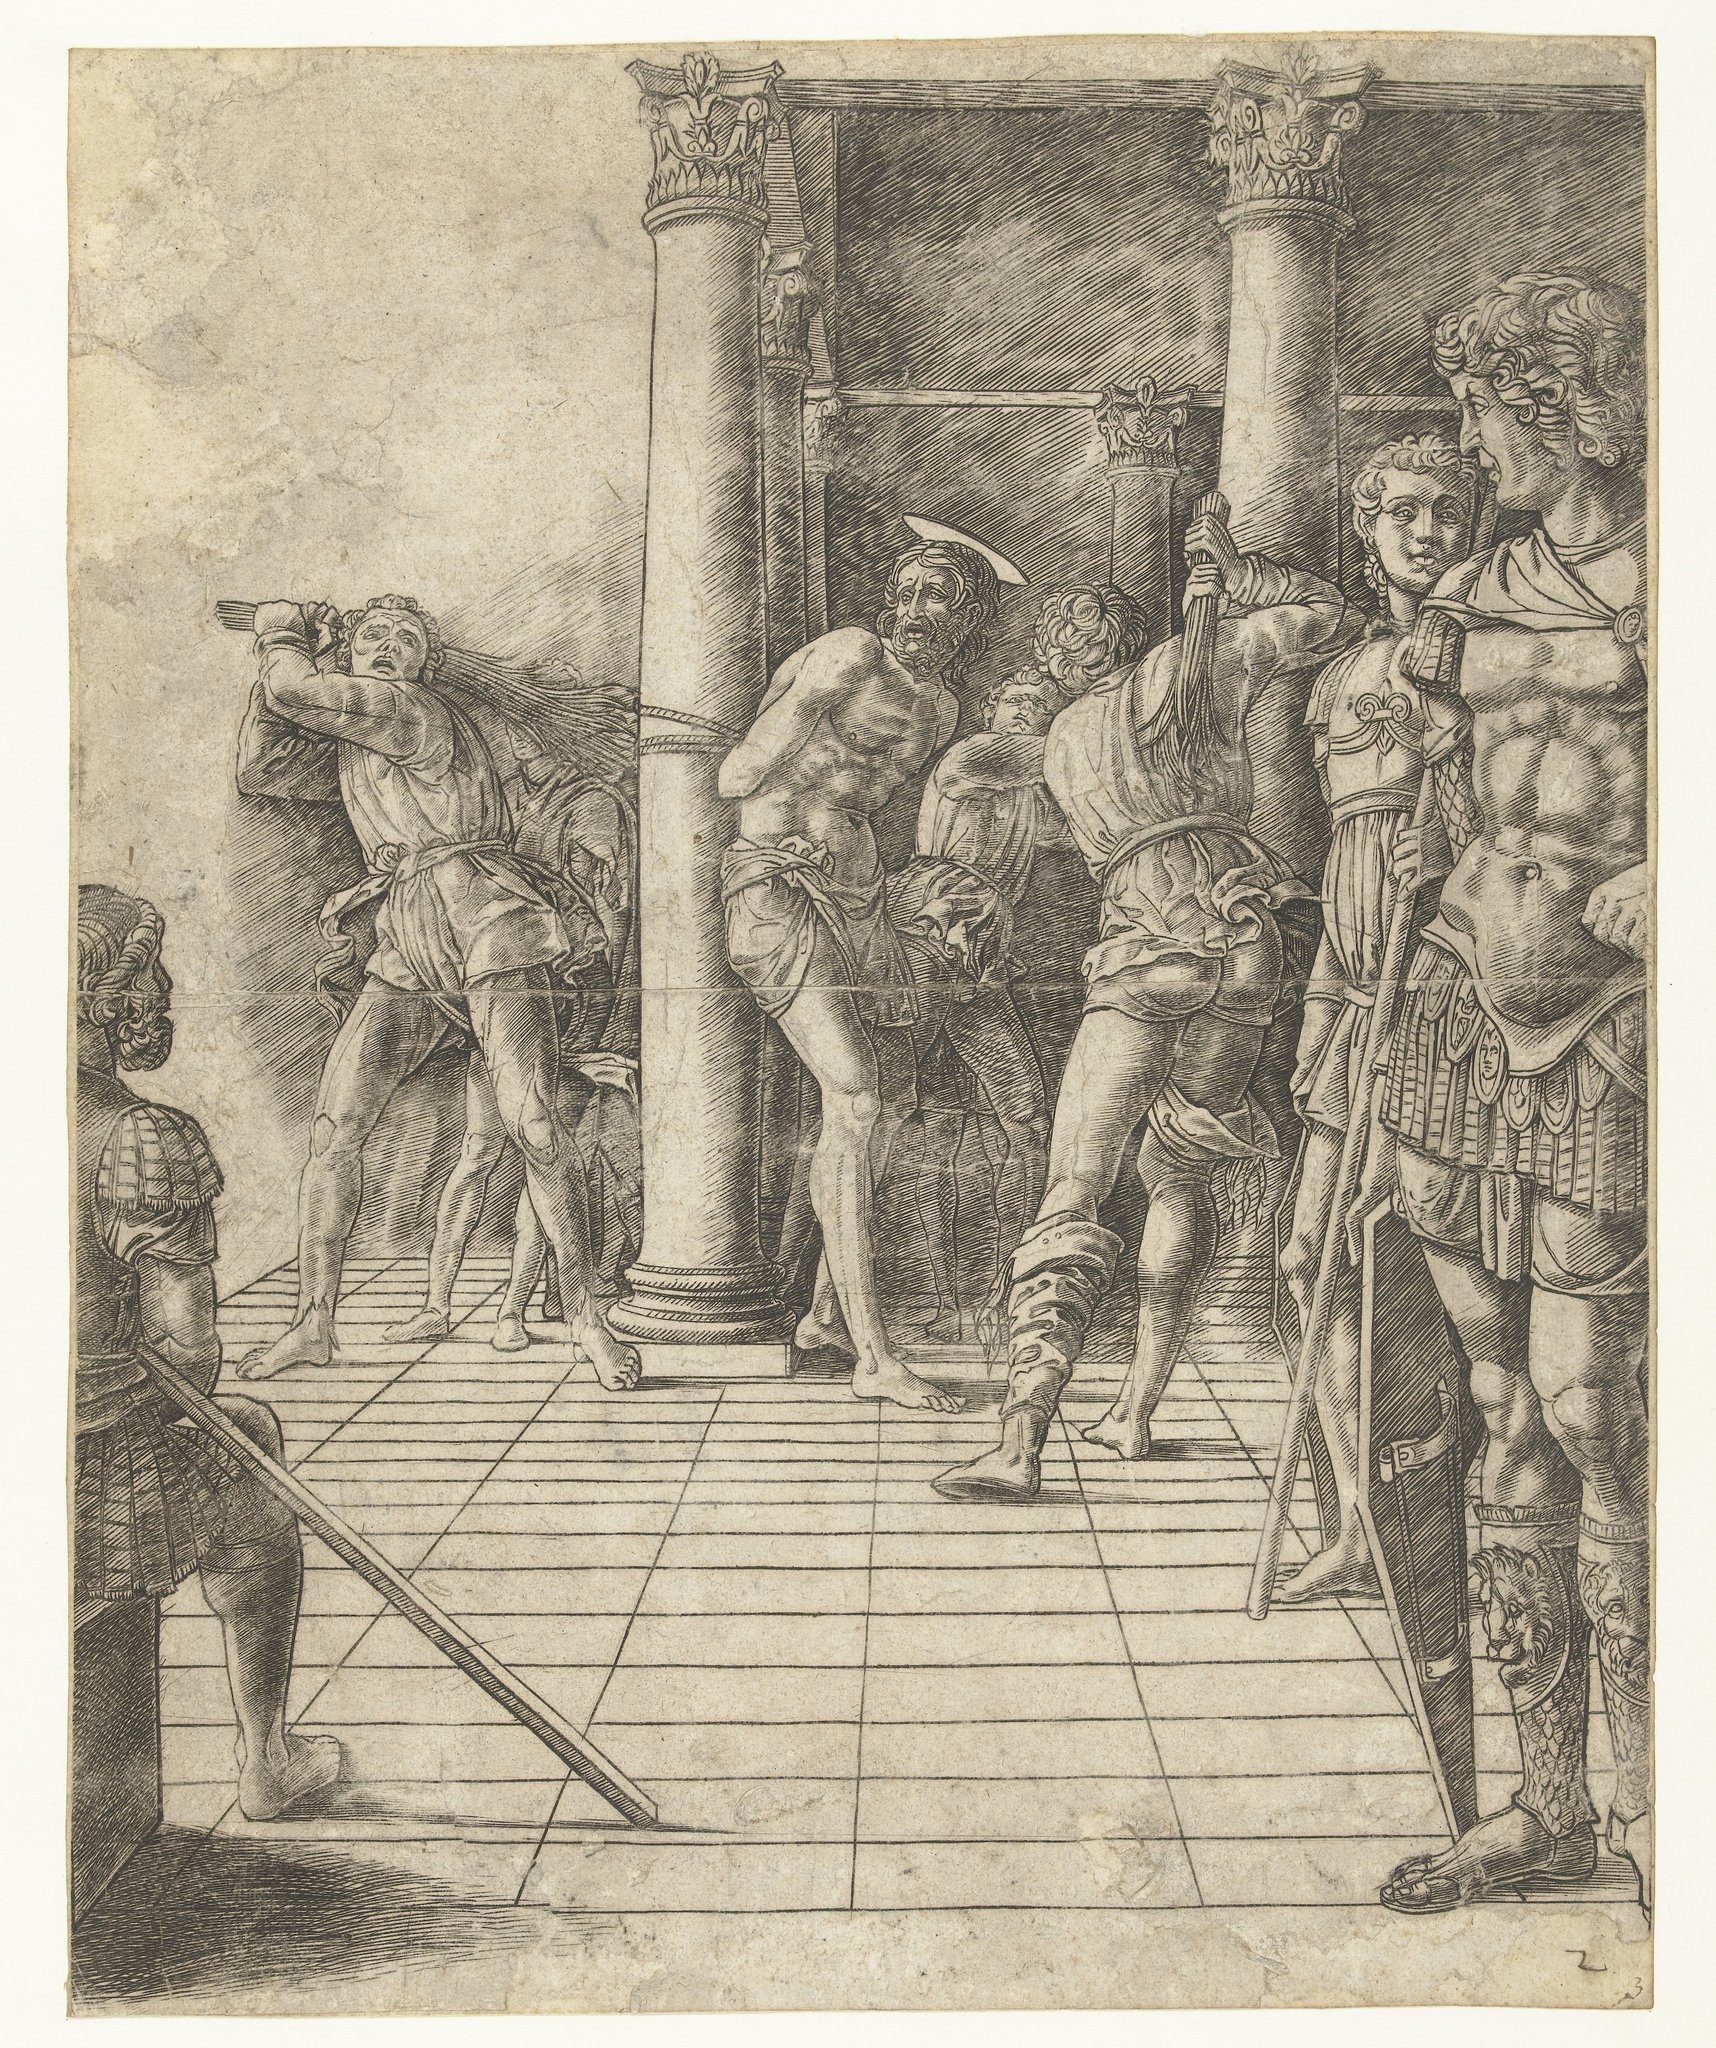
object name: print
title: Geseling van Christus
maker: andrea mantegna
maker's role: print maker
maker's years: 1431-1506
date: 1475-1480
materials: paper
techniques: engraving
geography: italy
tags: flagellation by soldiers, christ usually tied to a column (matthew 27:26; mark 15:15; john 19:1)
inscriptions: collector's mark: Lugt 10, inscription: ‘B 25 f 90-92’, collector's mark: ‘Hinloopen’ Lugt 11, collector's mark: Lugt 11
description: Christus staat vastgebonden aan een zuil in een zuilengang. Drie soldaten geselen hem met slagen. De voorstelling is onvoltooid links op de achtergrond en boven de zuilengang.